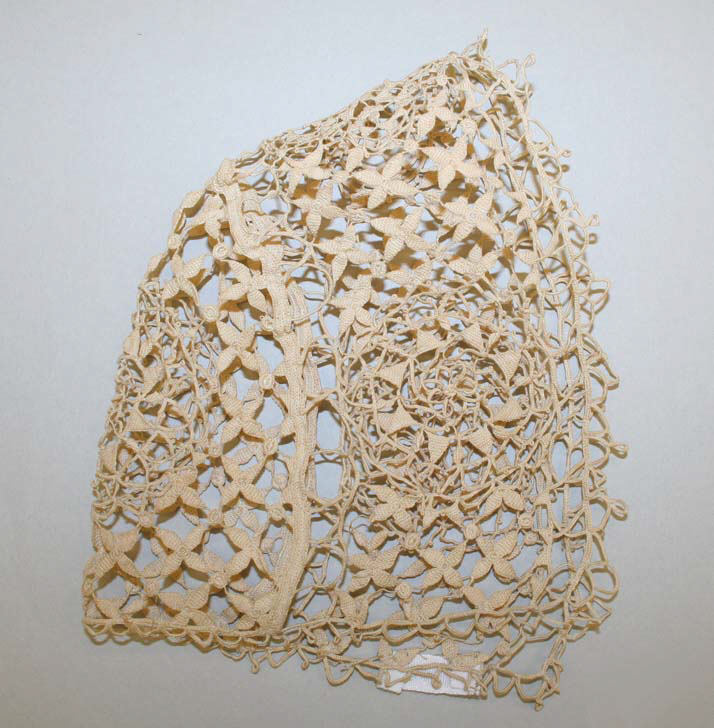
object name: bonnet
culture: european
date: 1801-1900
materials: linen